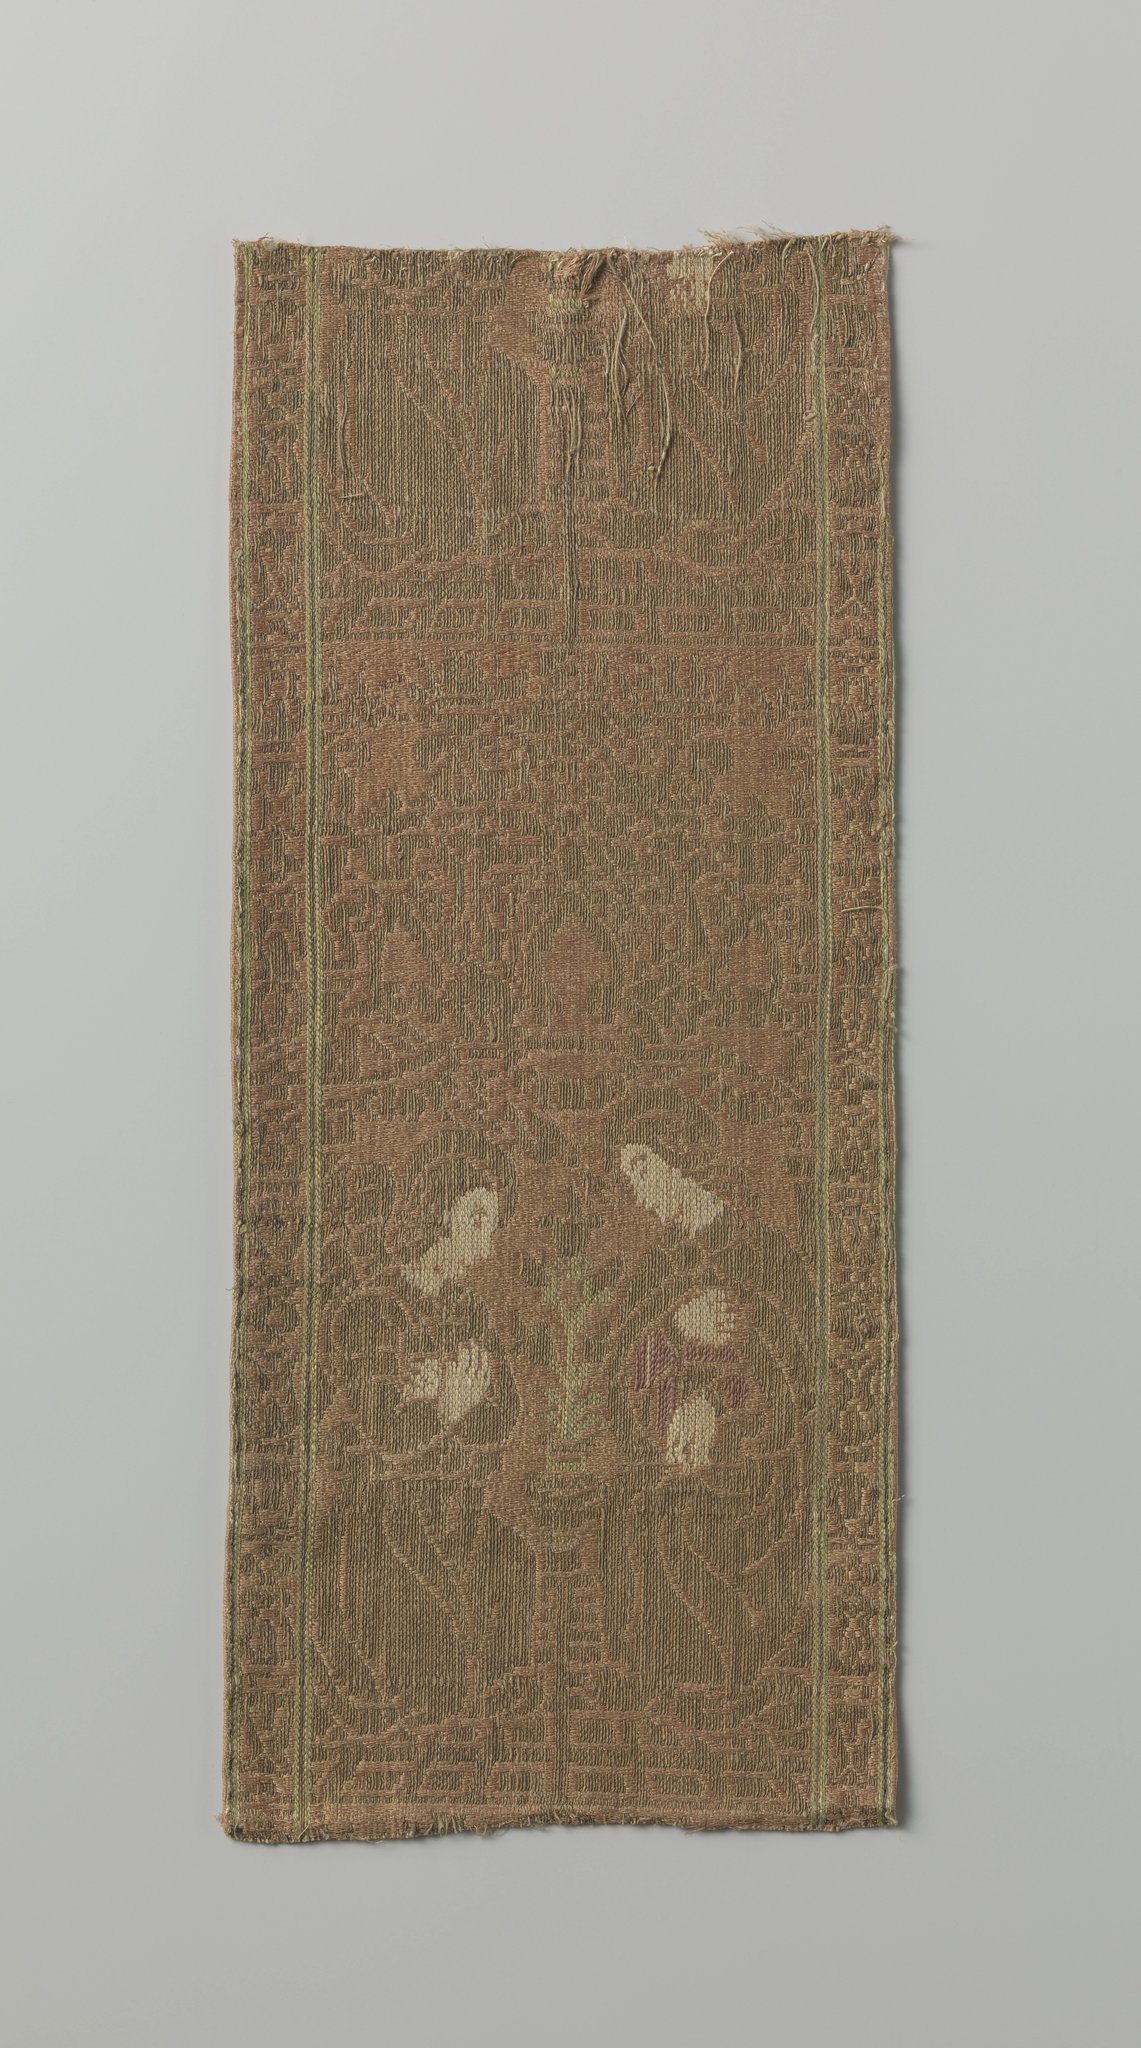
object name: band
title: Fragment van een decoratieve boord van een liturgisch gewaad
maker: Anonymous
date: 1400-1550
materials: textile, linen, metal thread, silk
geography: italy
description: Fragment van bruine zijde met voorstelling van de Boodschap van de engel Gabriël aan Maria, waarboven granaatappelpatroon en een deel van dezelfde voorstelling.